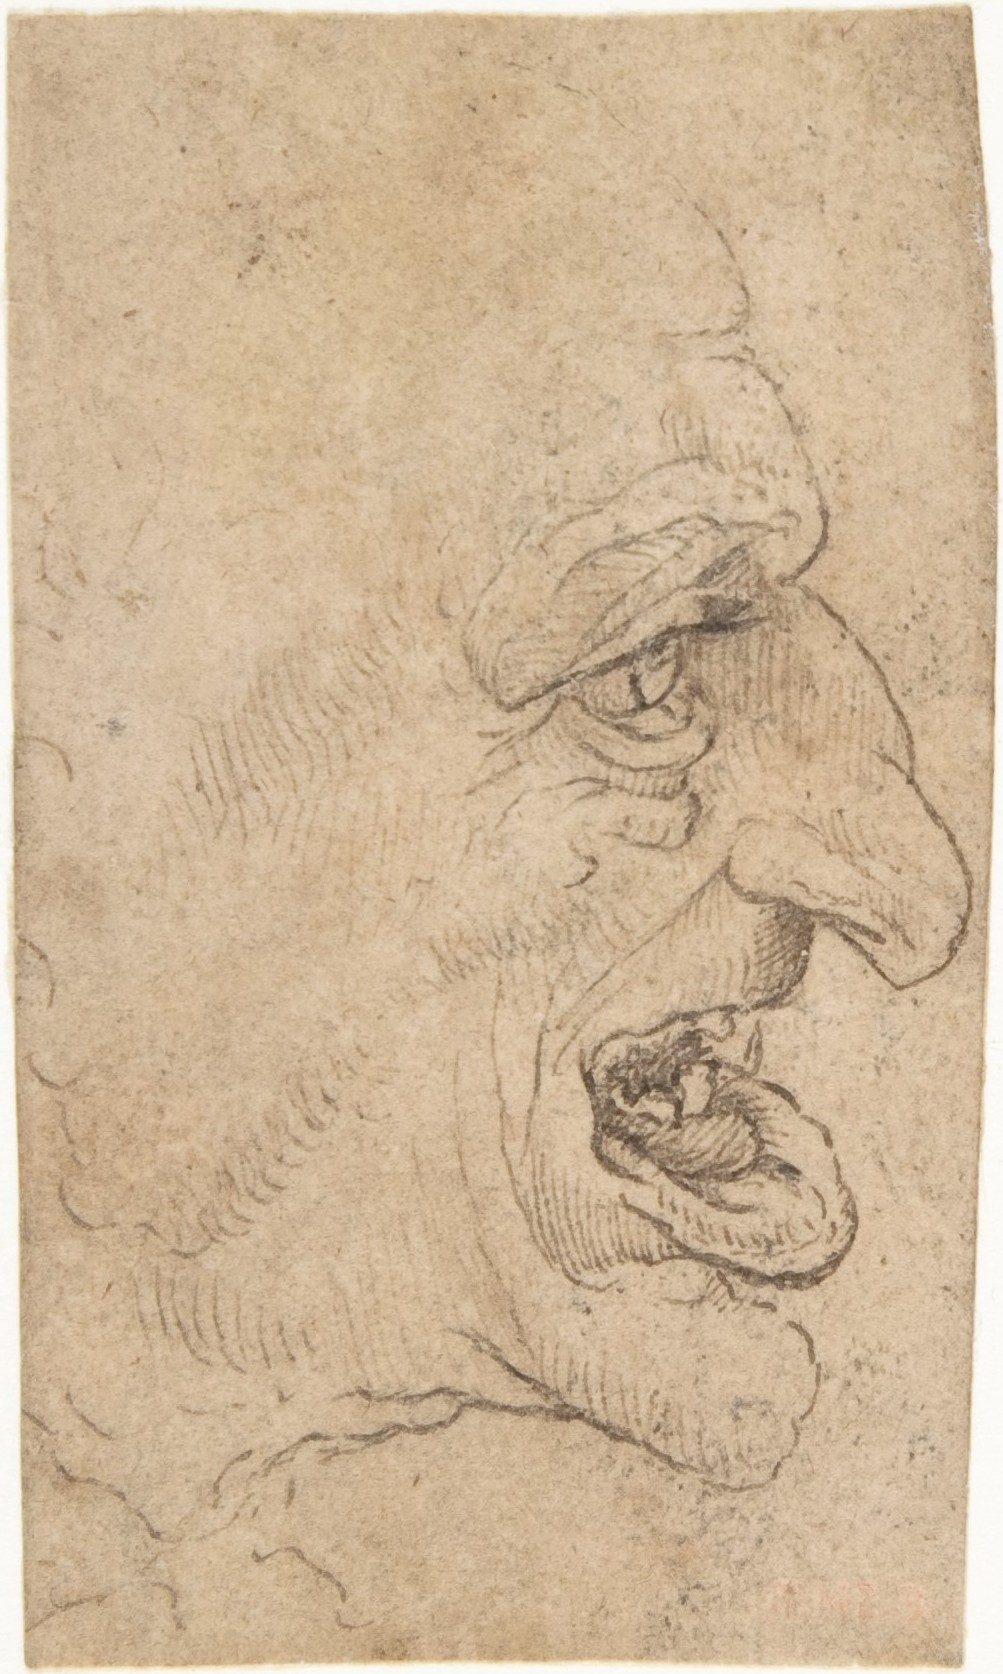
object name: drawing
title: The Head of a Grotesque Man in Profile Facing Right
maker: leonardo da vinci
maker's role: artist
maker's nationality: italian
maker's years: 1452-1519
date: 1500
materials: ink, paper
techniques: pen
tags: men,profiles